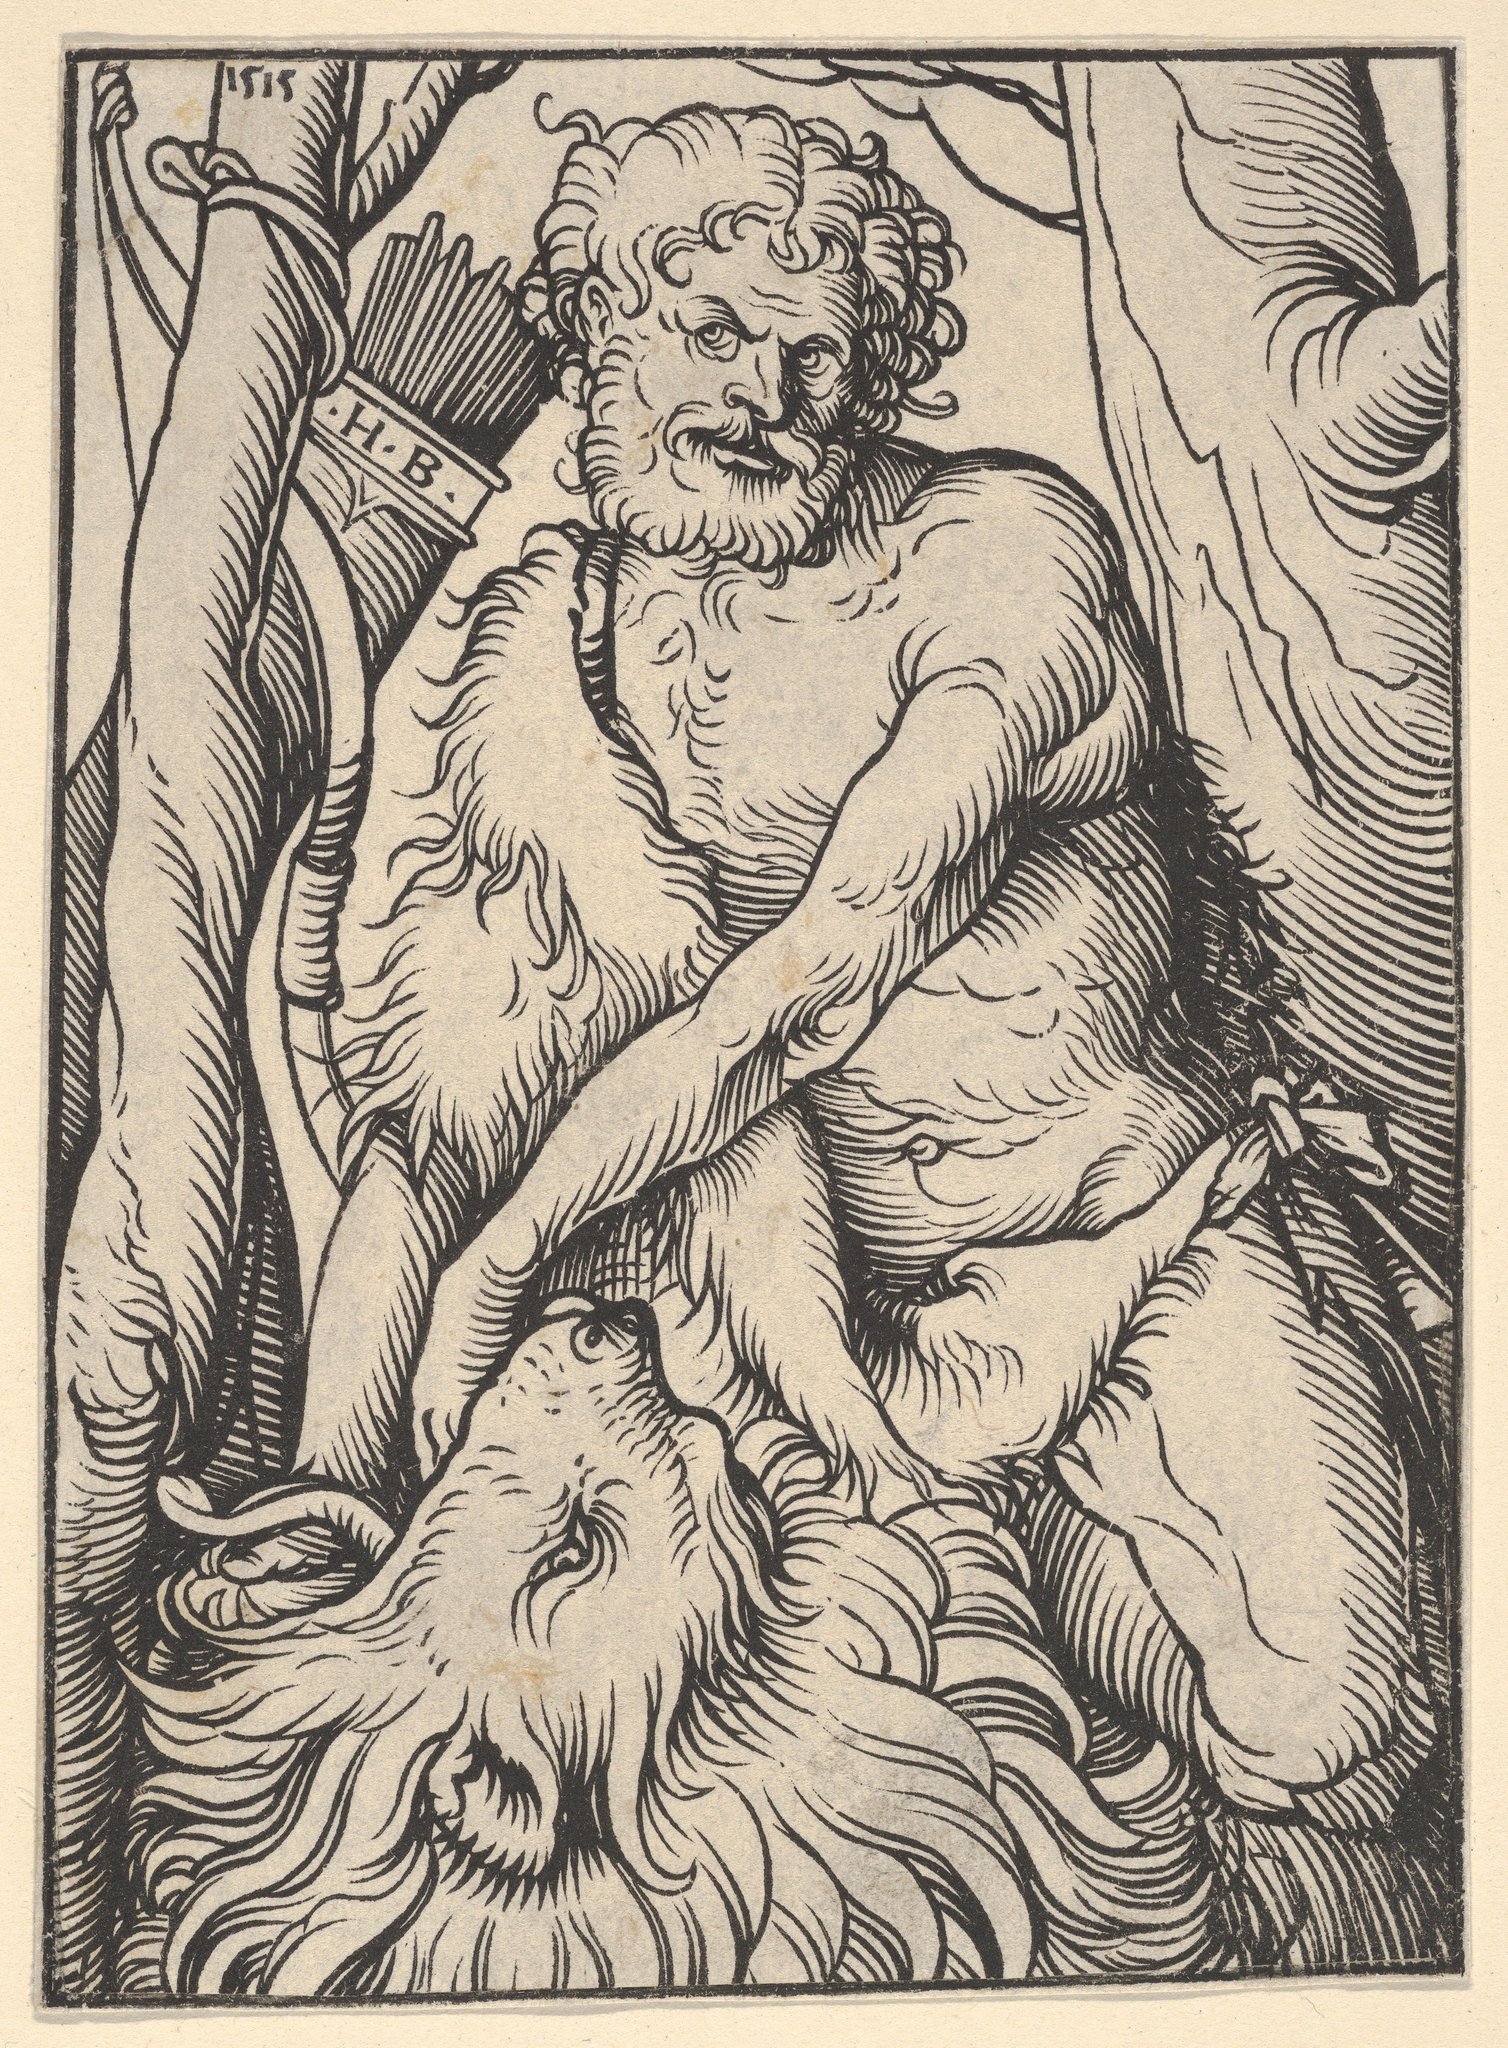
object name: print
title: Samson Killing the Lion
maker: hans burgkmair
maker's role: artist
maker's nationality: german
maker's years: 1473-1531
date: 1515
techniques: woodcut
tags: lions,samson